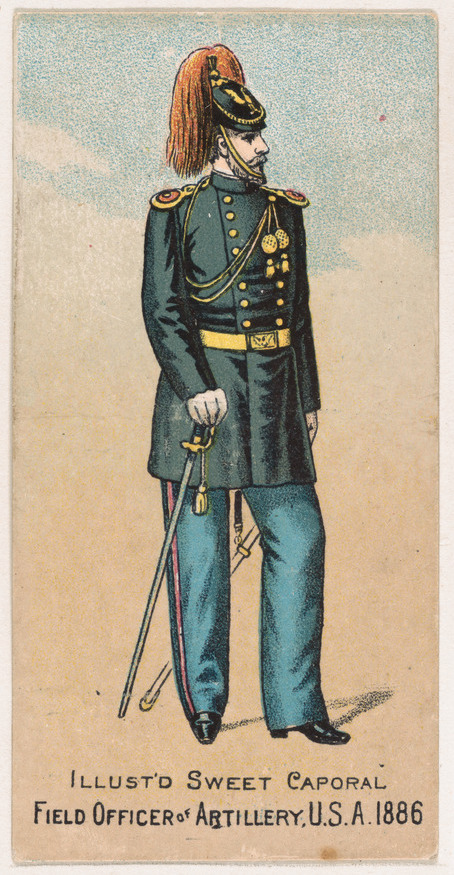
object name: print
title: Field Officer, Artillery, United States Army, 1886, from the Military Series (N224) issued by Kinney Tobacco Company to promote Sweet Caporal Cigarettes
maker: kinney brothers tobacco company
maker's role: publisher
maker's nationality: american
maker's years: 1869-2011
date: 1888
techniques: color lithograph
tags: army,swords,men